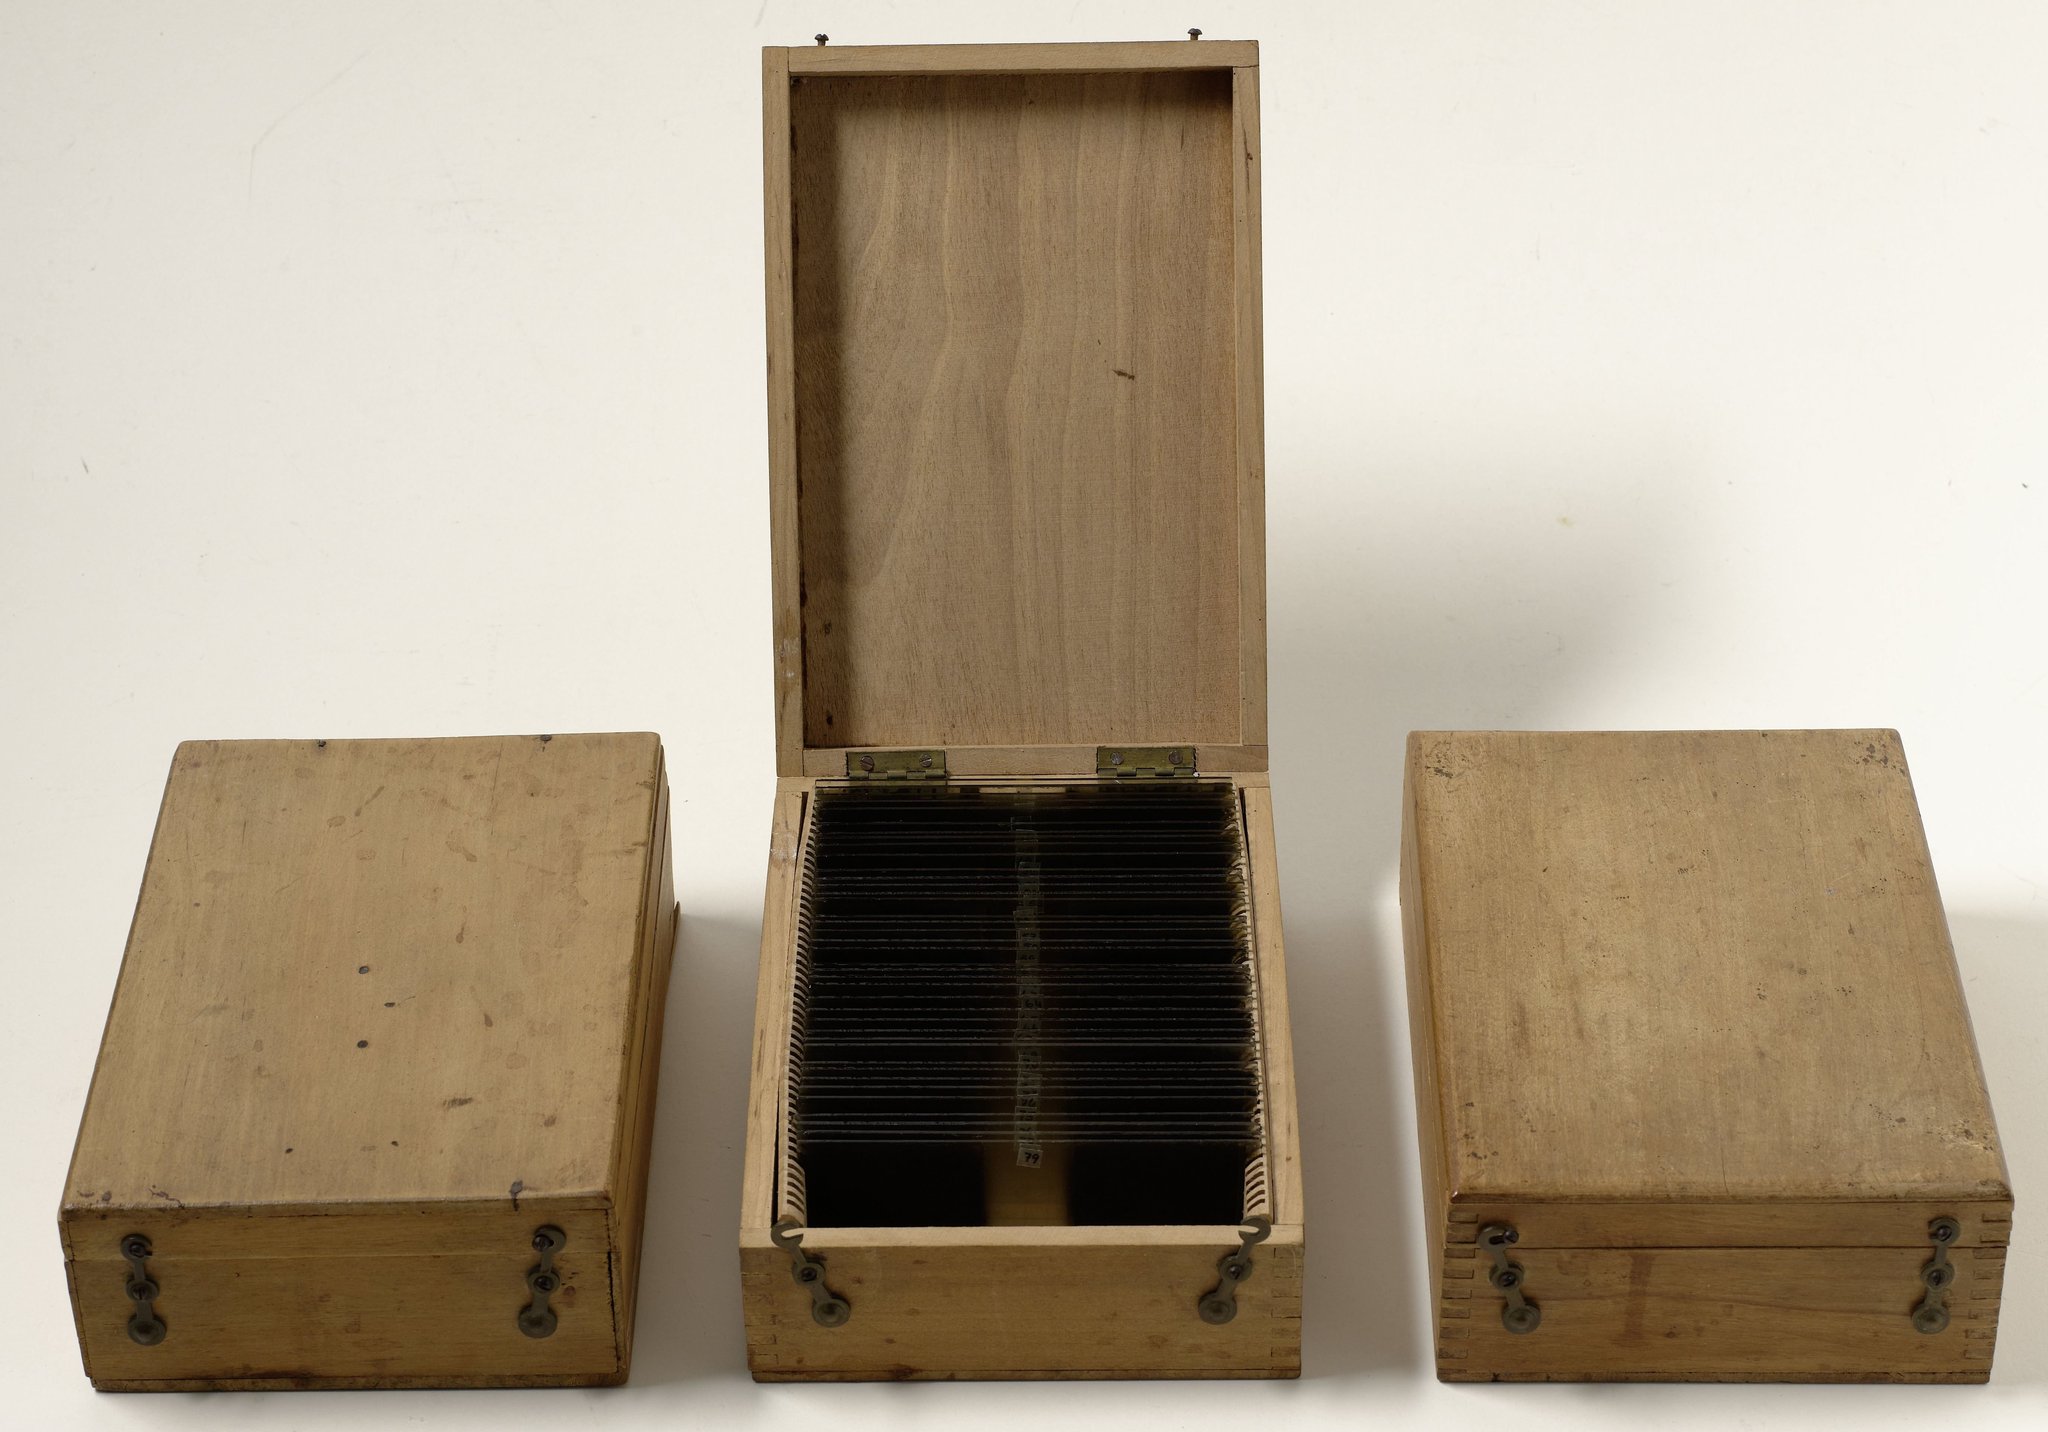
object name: stereograph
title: Plantage Accaribo, Suriname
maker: theodoor brouwers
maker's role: amateurfotograaf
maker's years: 1874-1932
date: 1913-1930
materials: glass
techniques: photography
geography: suriname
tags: amsterdam, theodoor brouwers, suriname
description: Drie houten dozen met 120 stereofoto's op glas die een beeld geven van het dagelijkse leven op plantage Accaribo in Suriname, ca. 1913-1930, een voormalige suikerplantage aan de Surinamerivier. Op deze plantage woonde de familie Brouwers. Theodoor Brouwers is mogelijk de fotograaf en fotografeerde de familie, de plantage, het huispersoneel, het familieleven in Paramaribo en uitstapjes. Een achttal foto's is genomen in Nederland.